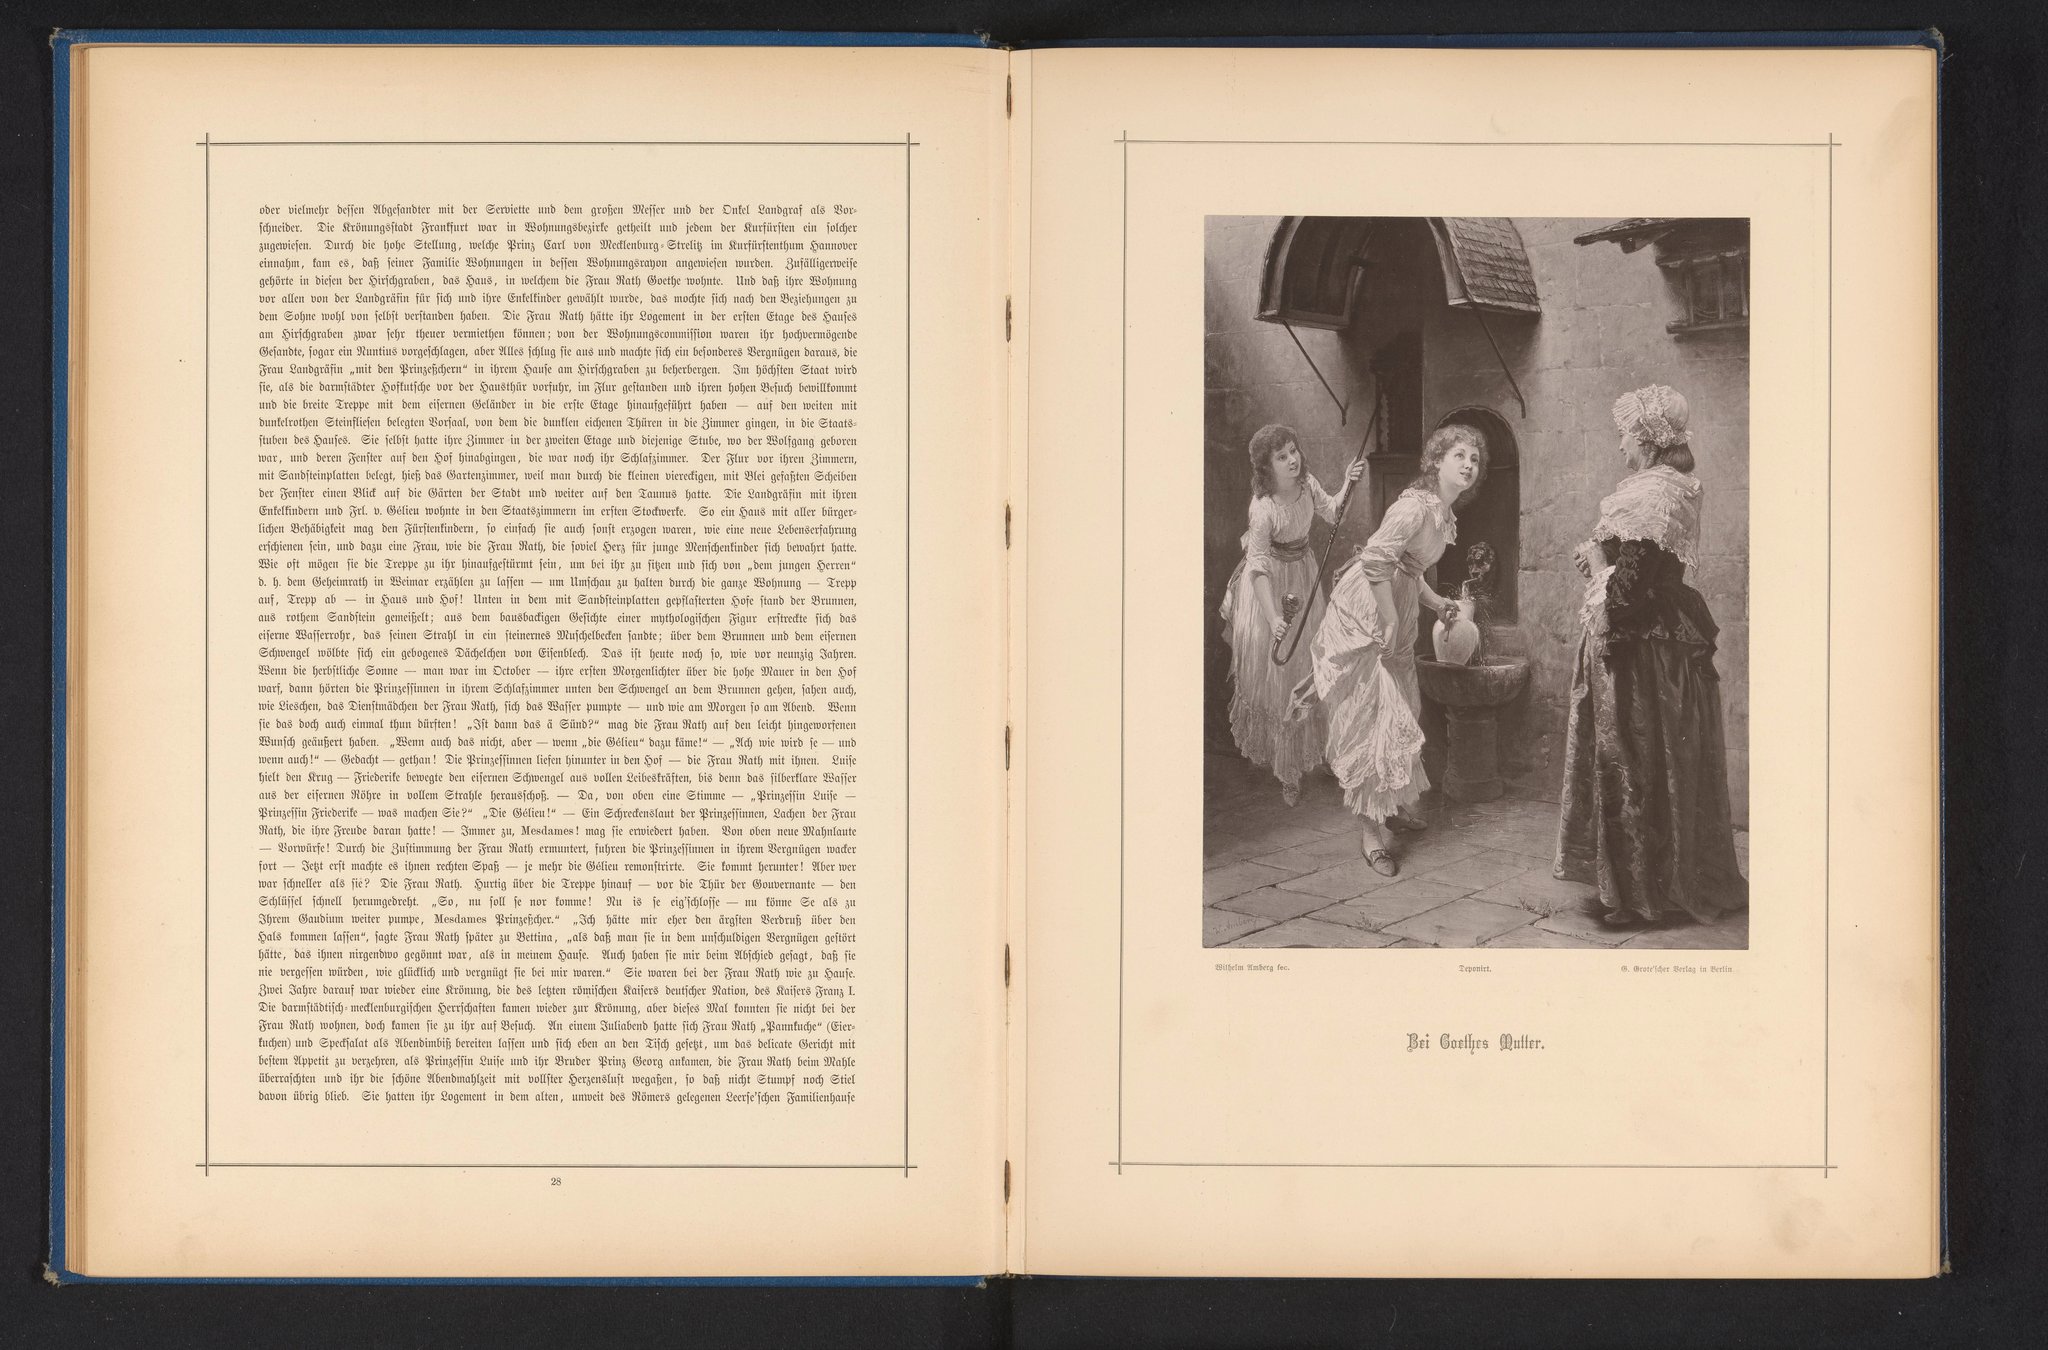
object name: photomechanical print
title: Bei Goethes Mutter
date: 1873-1883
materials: paper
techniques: photograph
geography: berlin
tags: crown princess, princess, courtyard